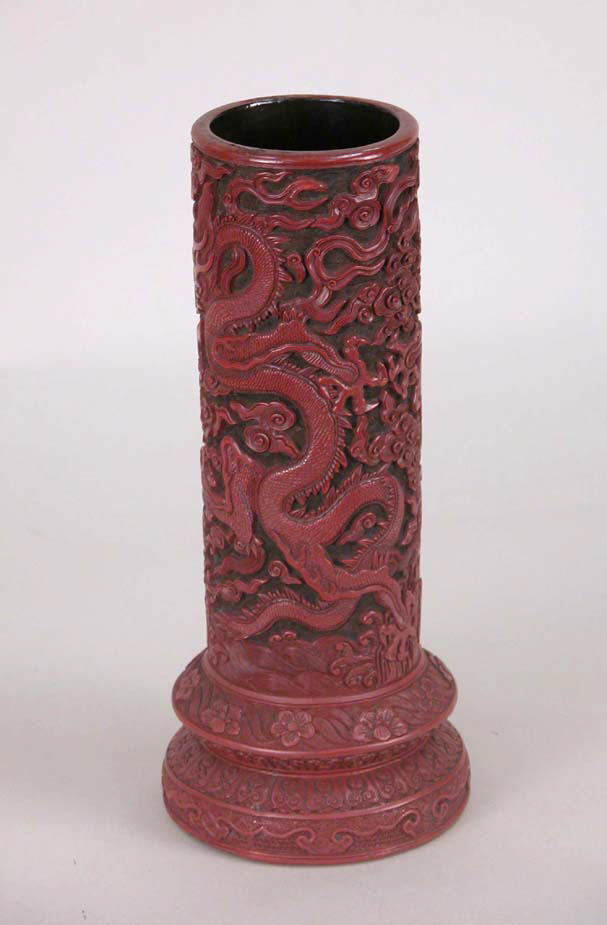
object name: brush holder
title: Brush holder with dragons and clouds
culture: chinese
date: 1522-1566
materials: lacquer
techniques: carving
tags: clouds